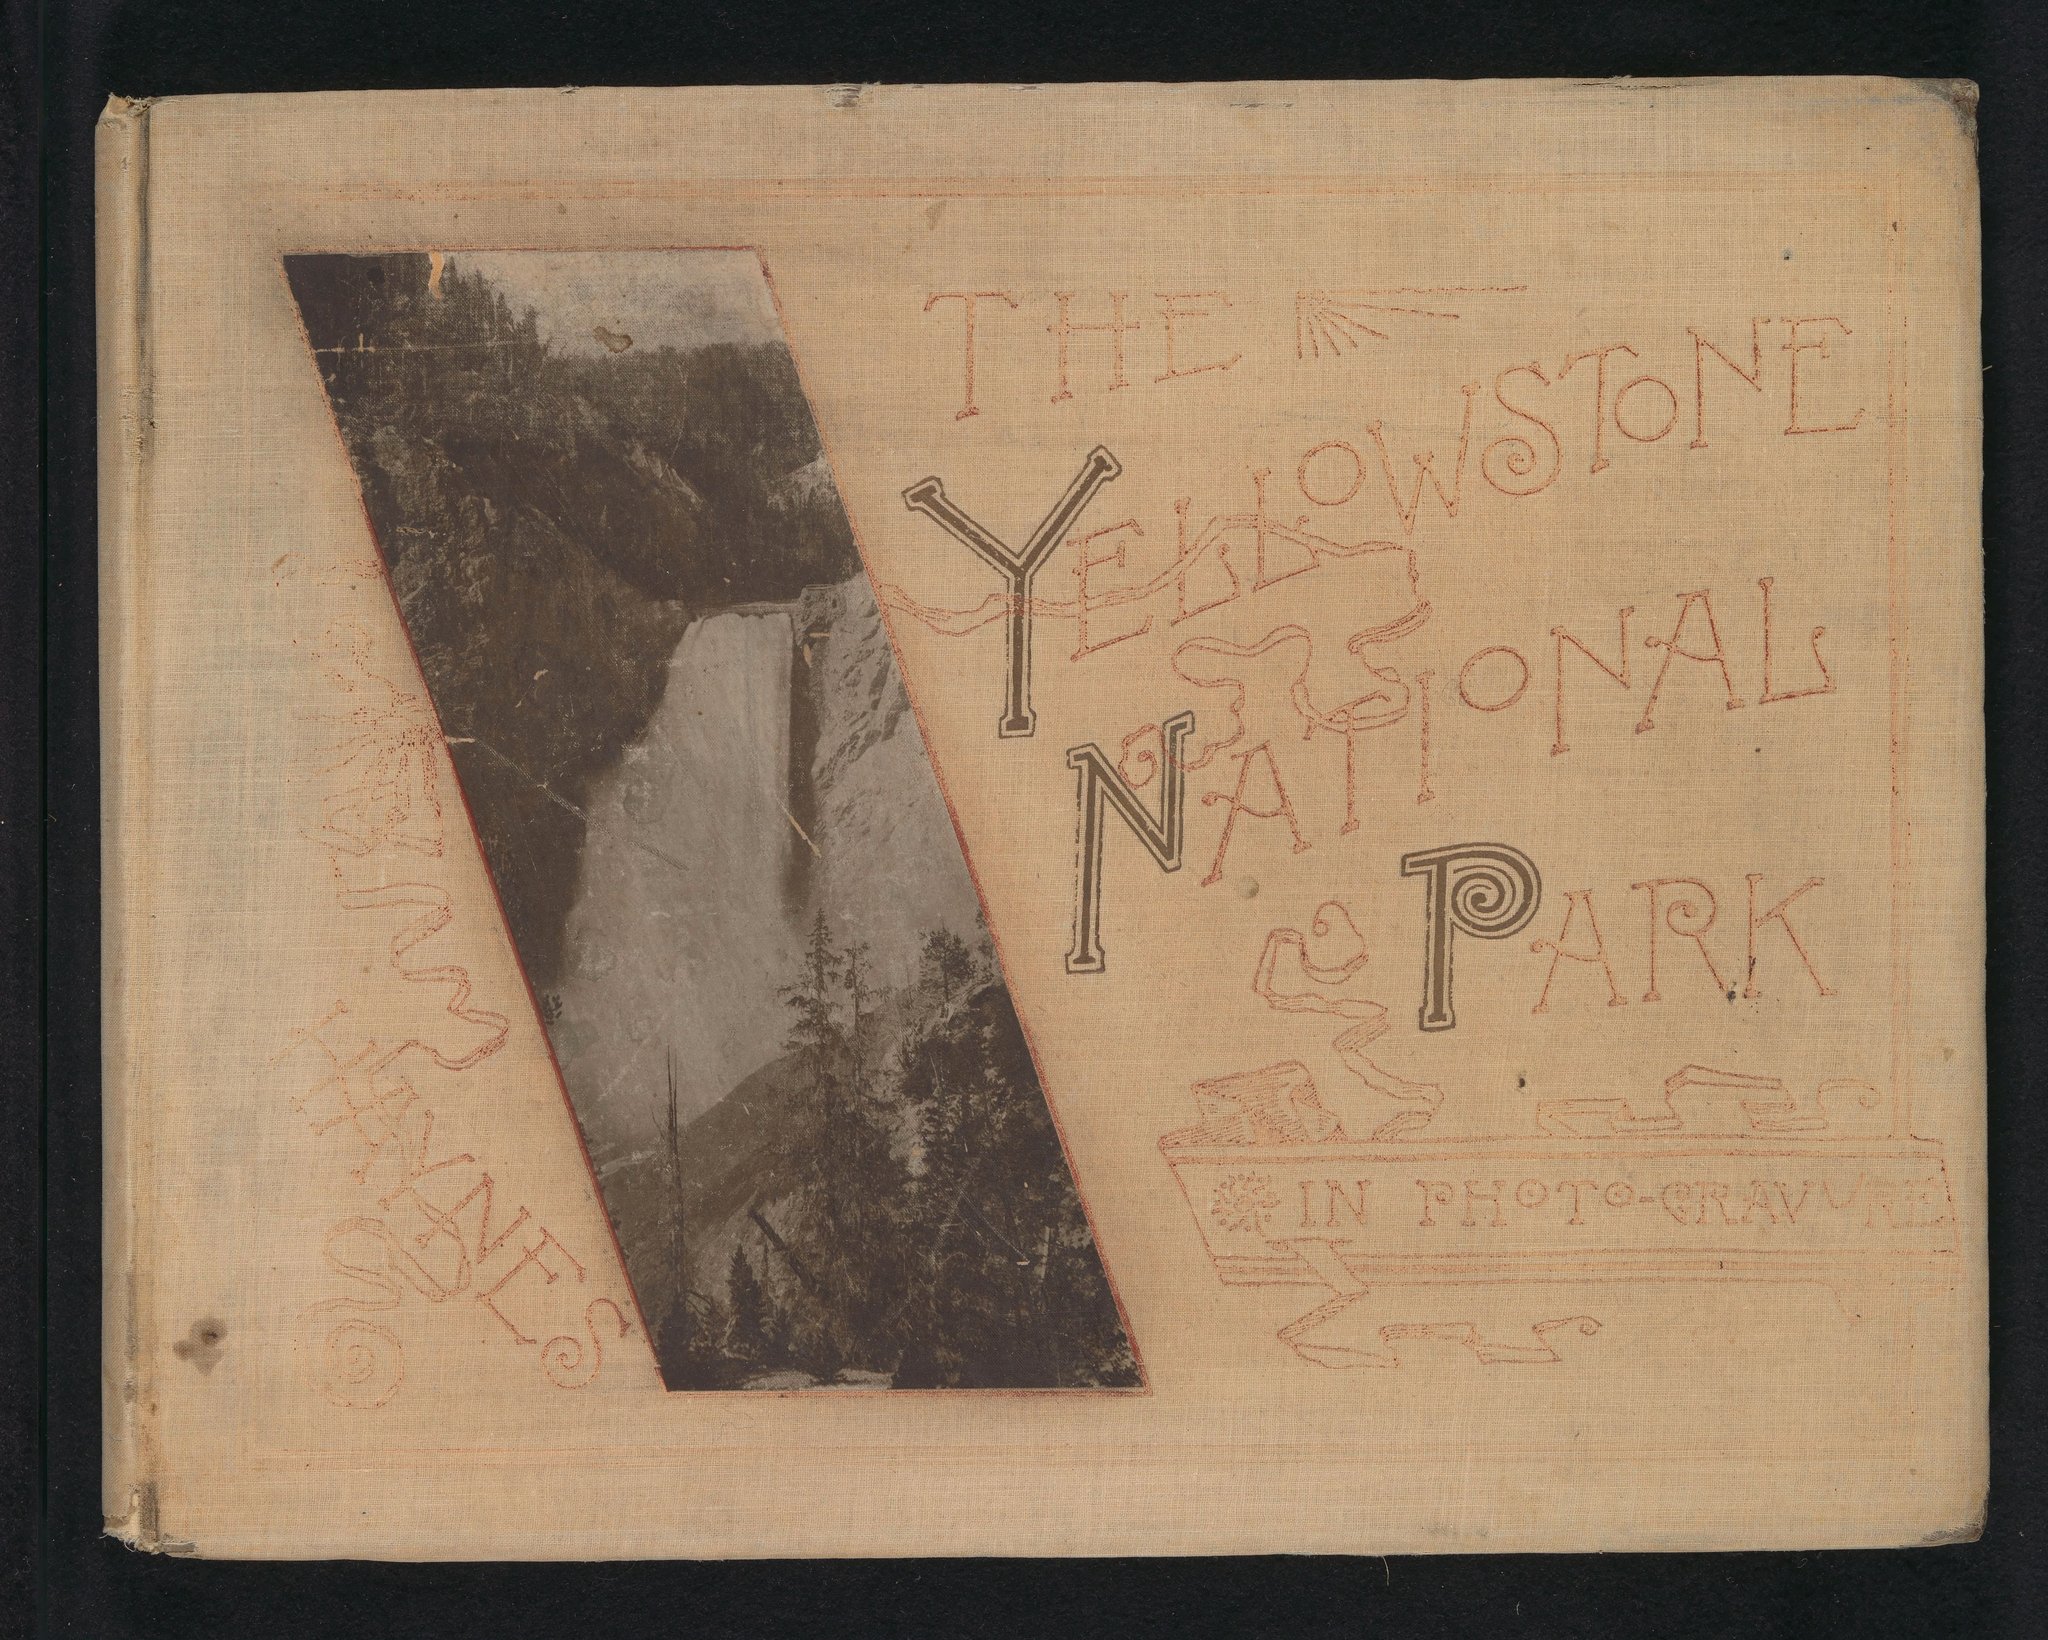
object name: page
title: Gezicht op de Lower Yellowstone Falls in het Yellowstone National Park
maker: frank jay haynes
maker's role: fotograaf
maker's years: 1853-1921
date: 1882-1887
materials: linen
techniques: photoaquatint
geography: yellowstone national park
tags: waterfall